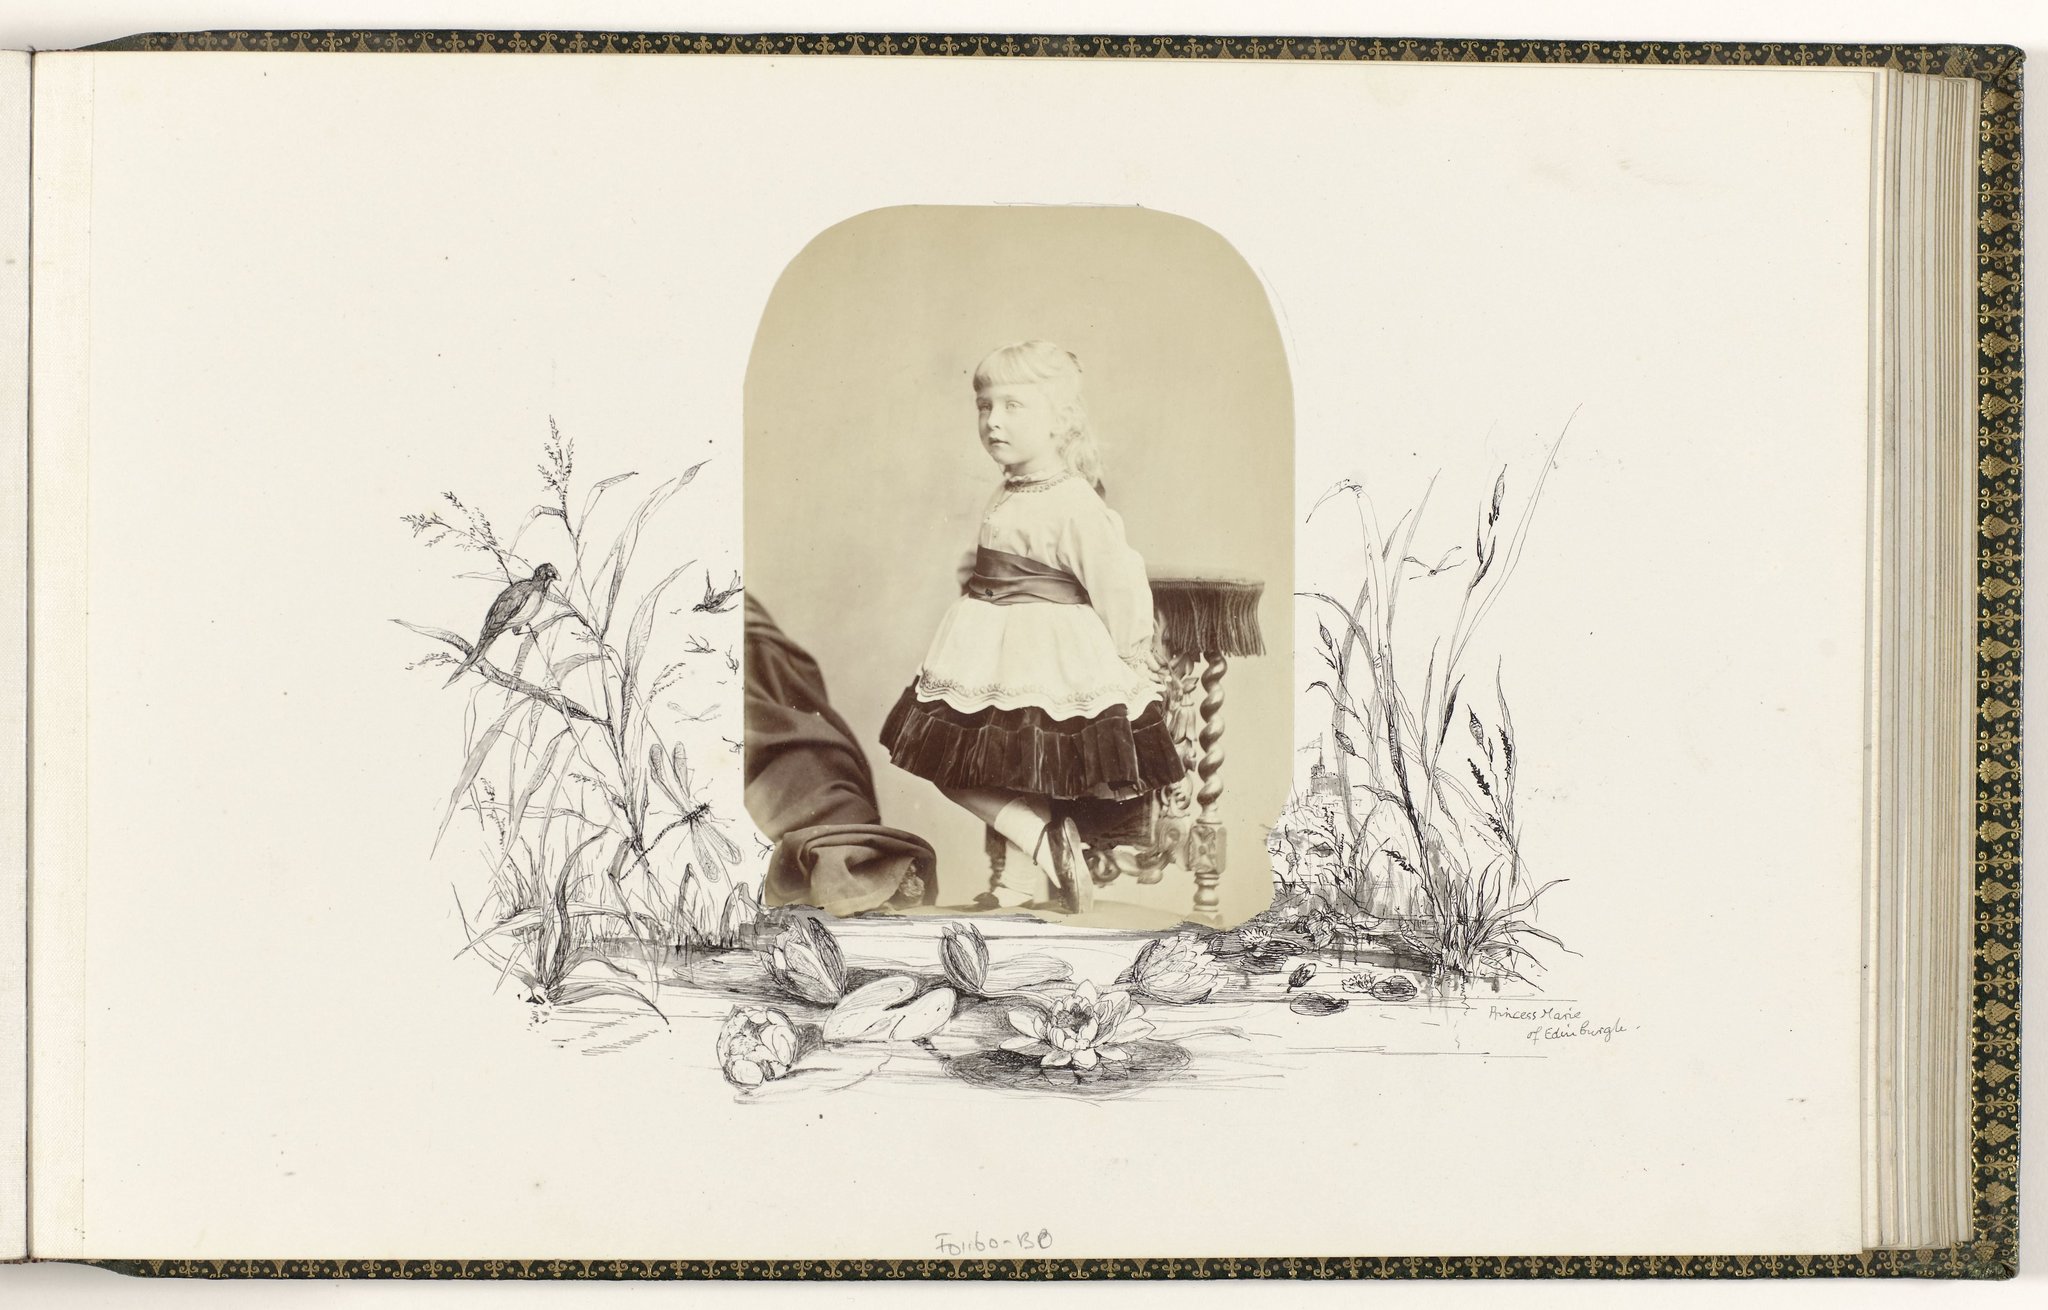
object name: photograph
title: Portret van prinses Marie van Edinburgh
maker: Anonymous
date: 1875-1880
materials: paper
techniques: albumen print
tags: historical persons, princess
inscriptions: inscription: ‘Princess Marie/ of Edinburgh.’